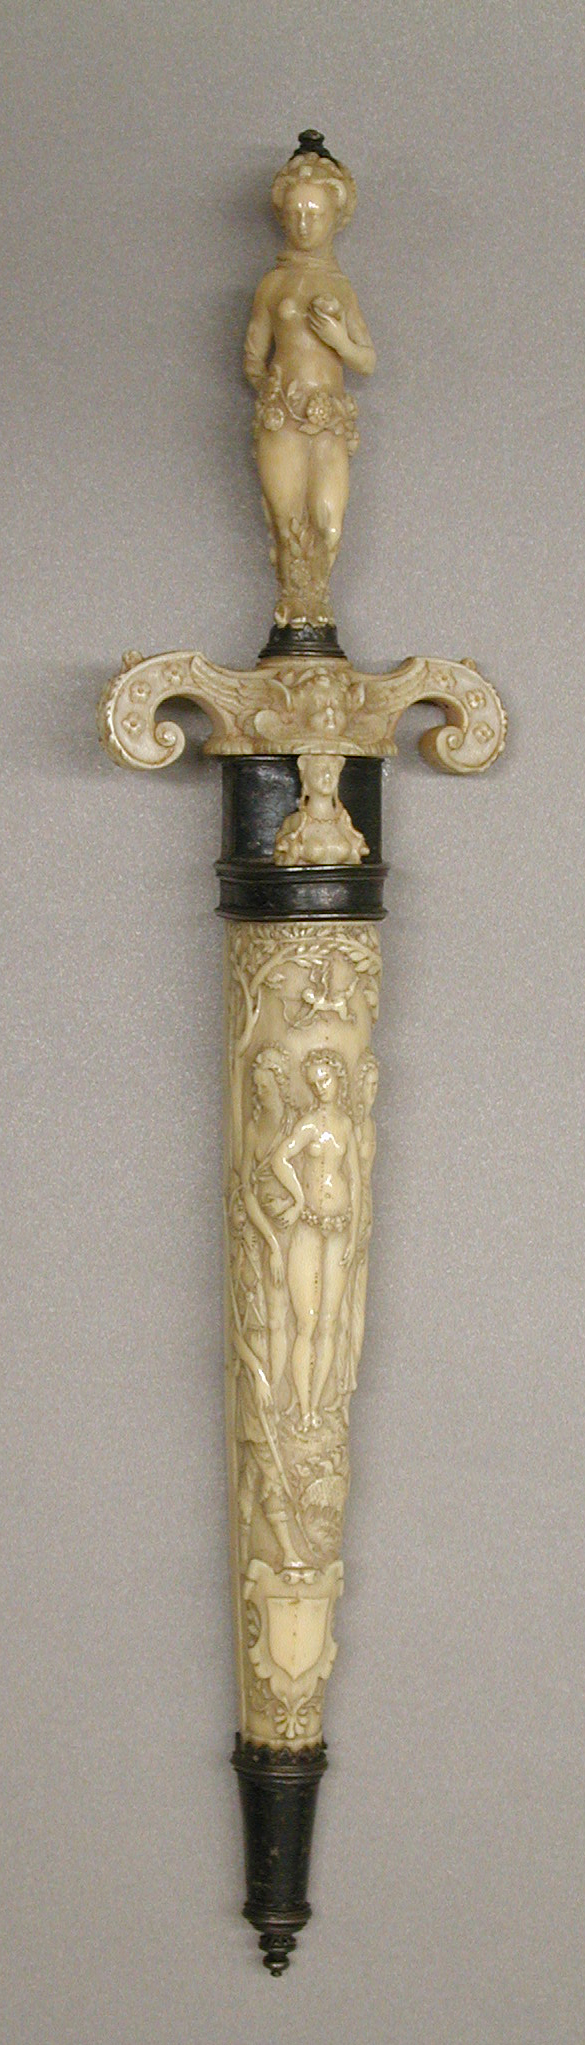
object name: dagger with sheath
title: Dagger with Sheath and Knife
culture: french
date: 1801-1833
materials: gold, ivory, silver, steel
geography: england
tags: women